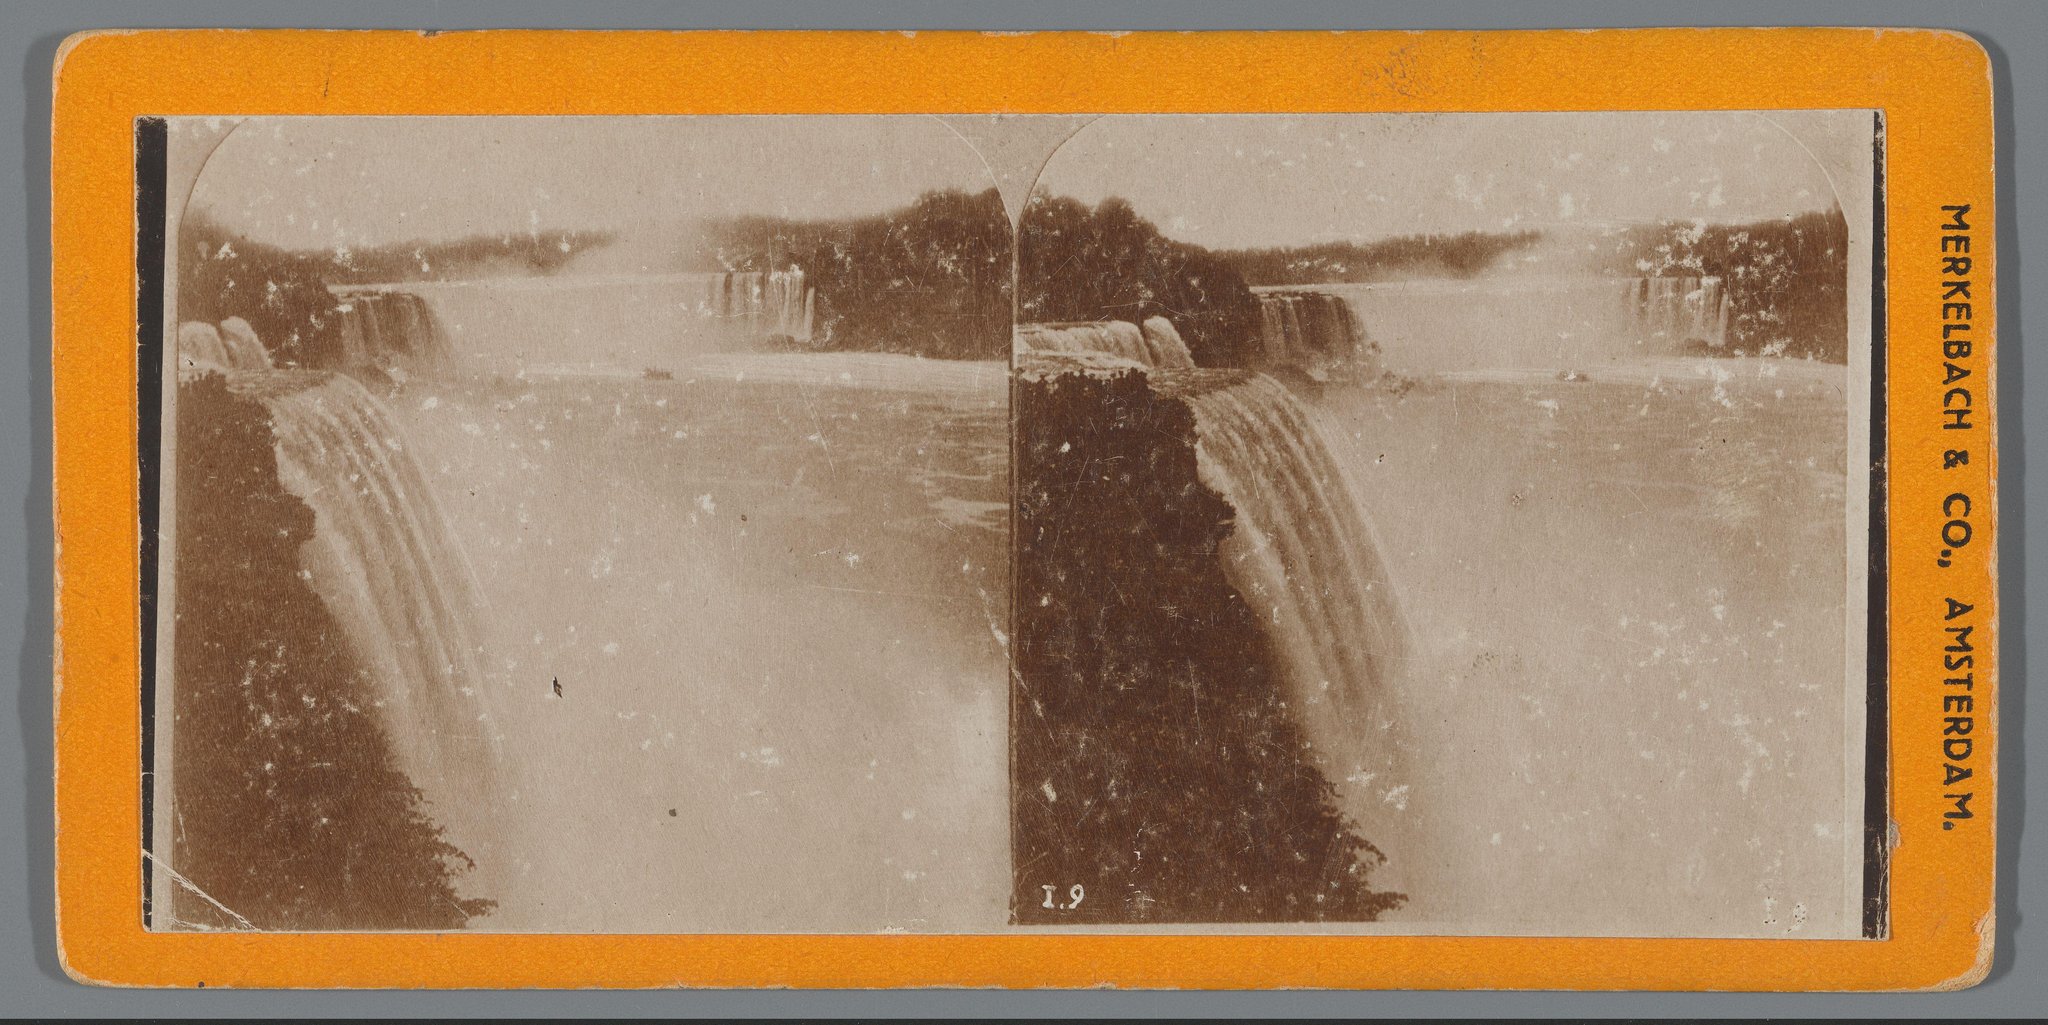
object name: stereograph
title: Aardrijkskundige Beeldengalerij, verzameld door M.J. Broekhuijsen, Hoofd eener school te Amsterdam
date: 1905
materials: paper, cardboard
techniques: collodion silver print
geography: amsterdam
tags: niagara falls